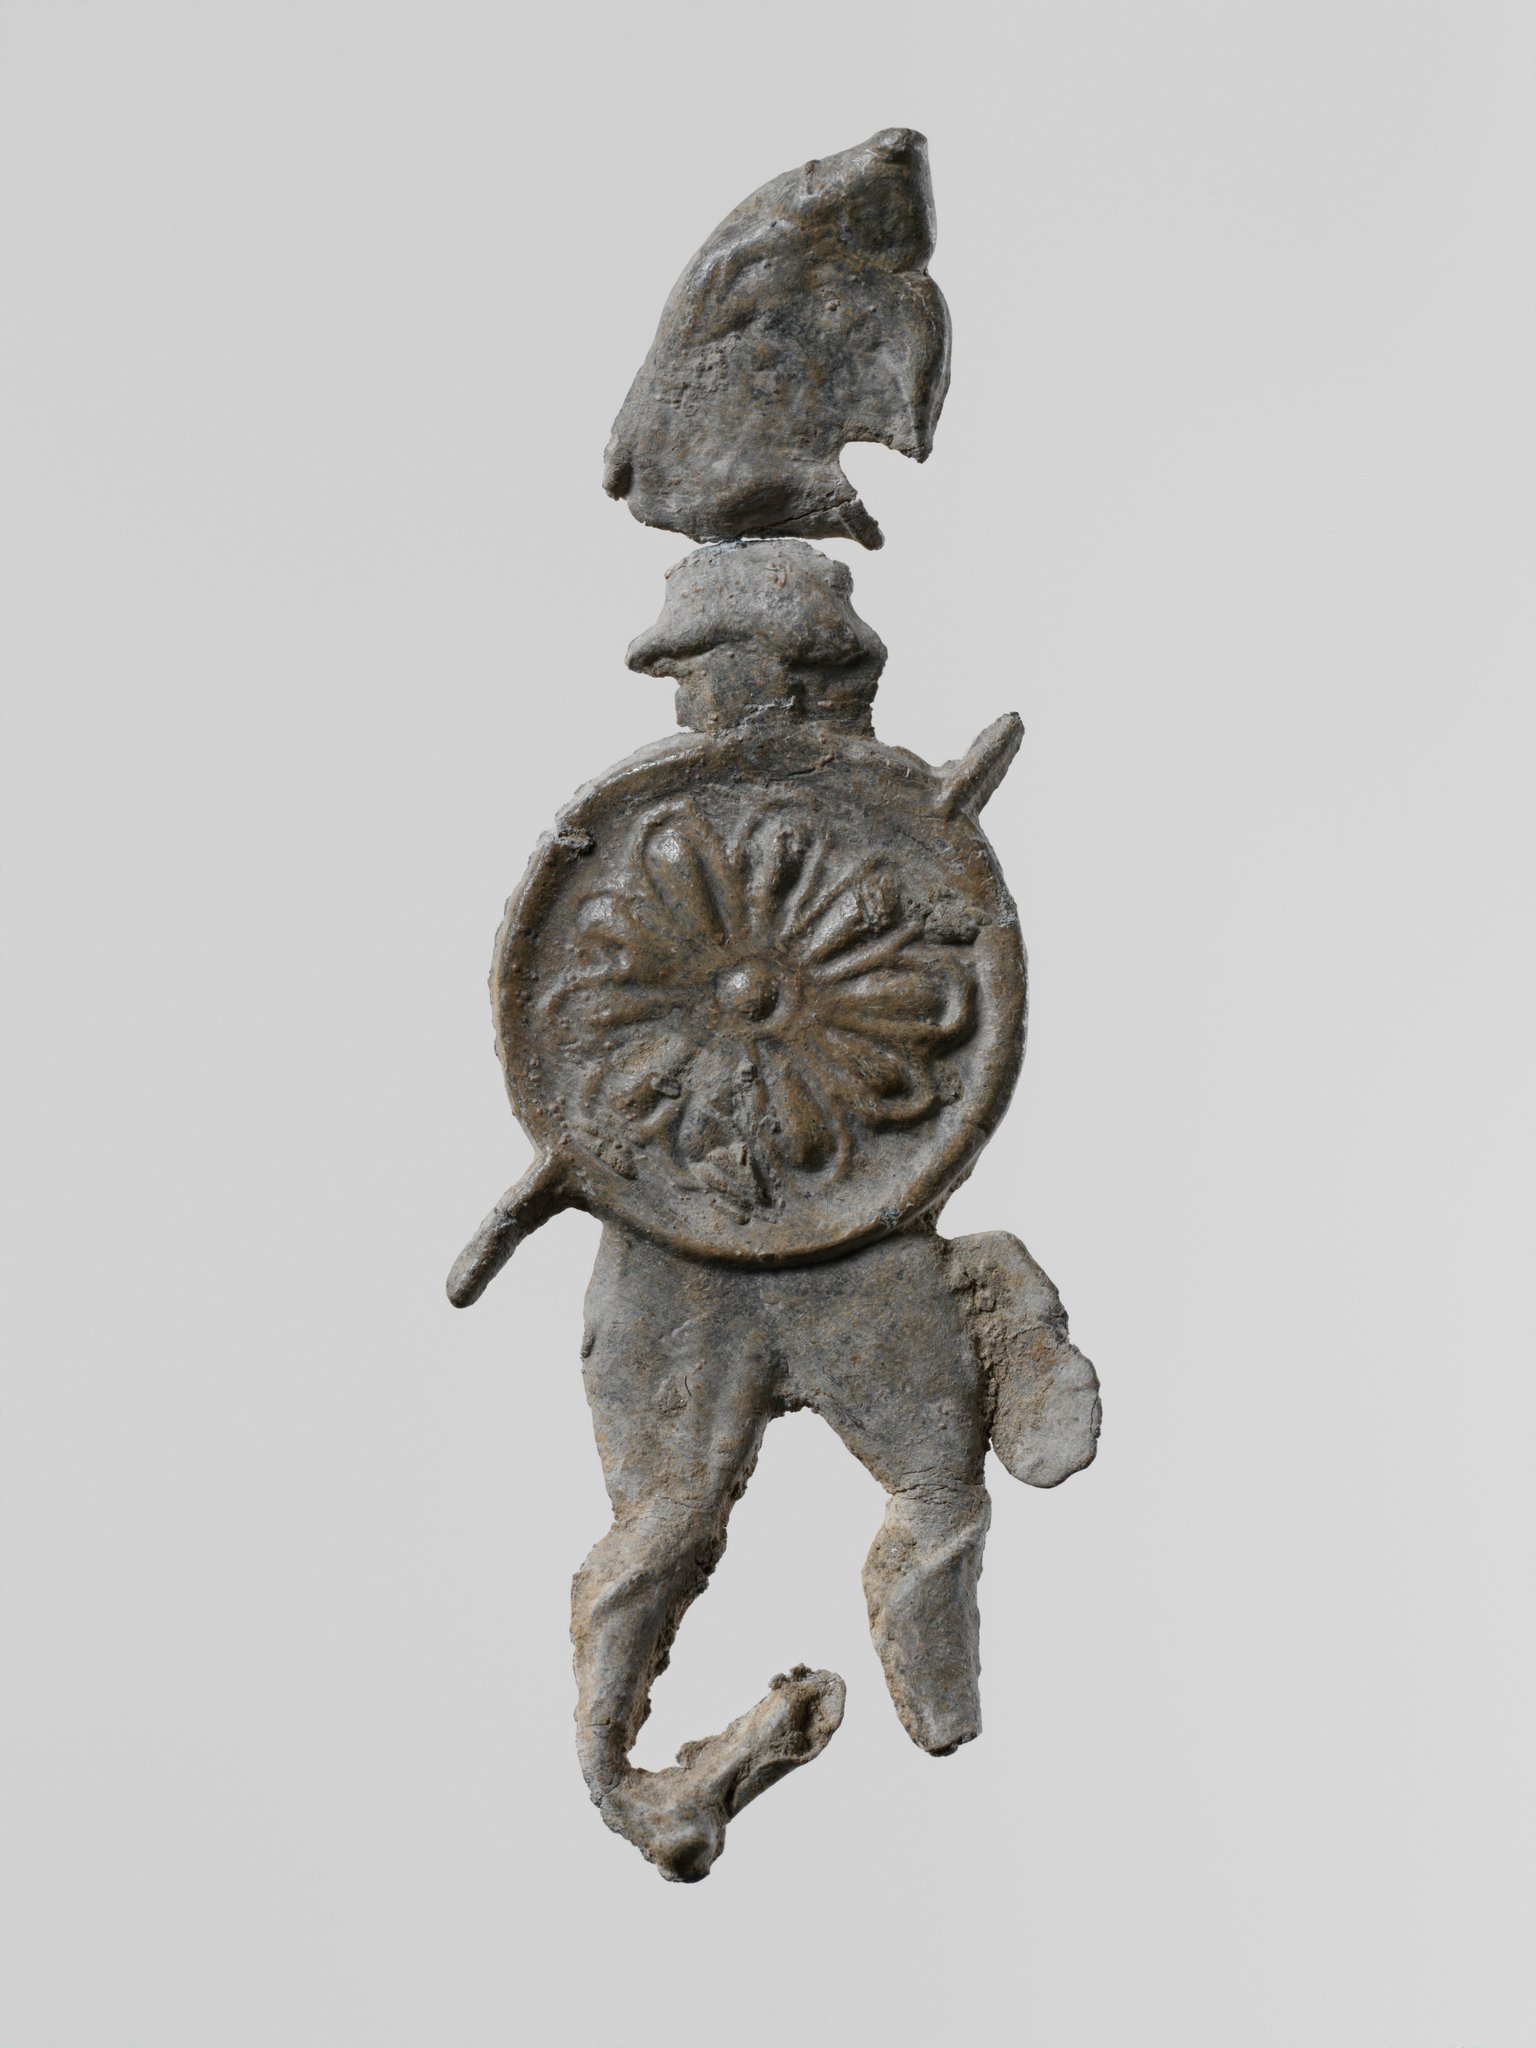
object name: statuette of a warrior, 10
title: Lead figure of a warrior with a helmet and shield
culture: greek, laconian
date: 600-401 BCE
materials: lead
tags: soldiers,helmets,shields